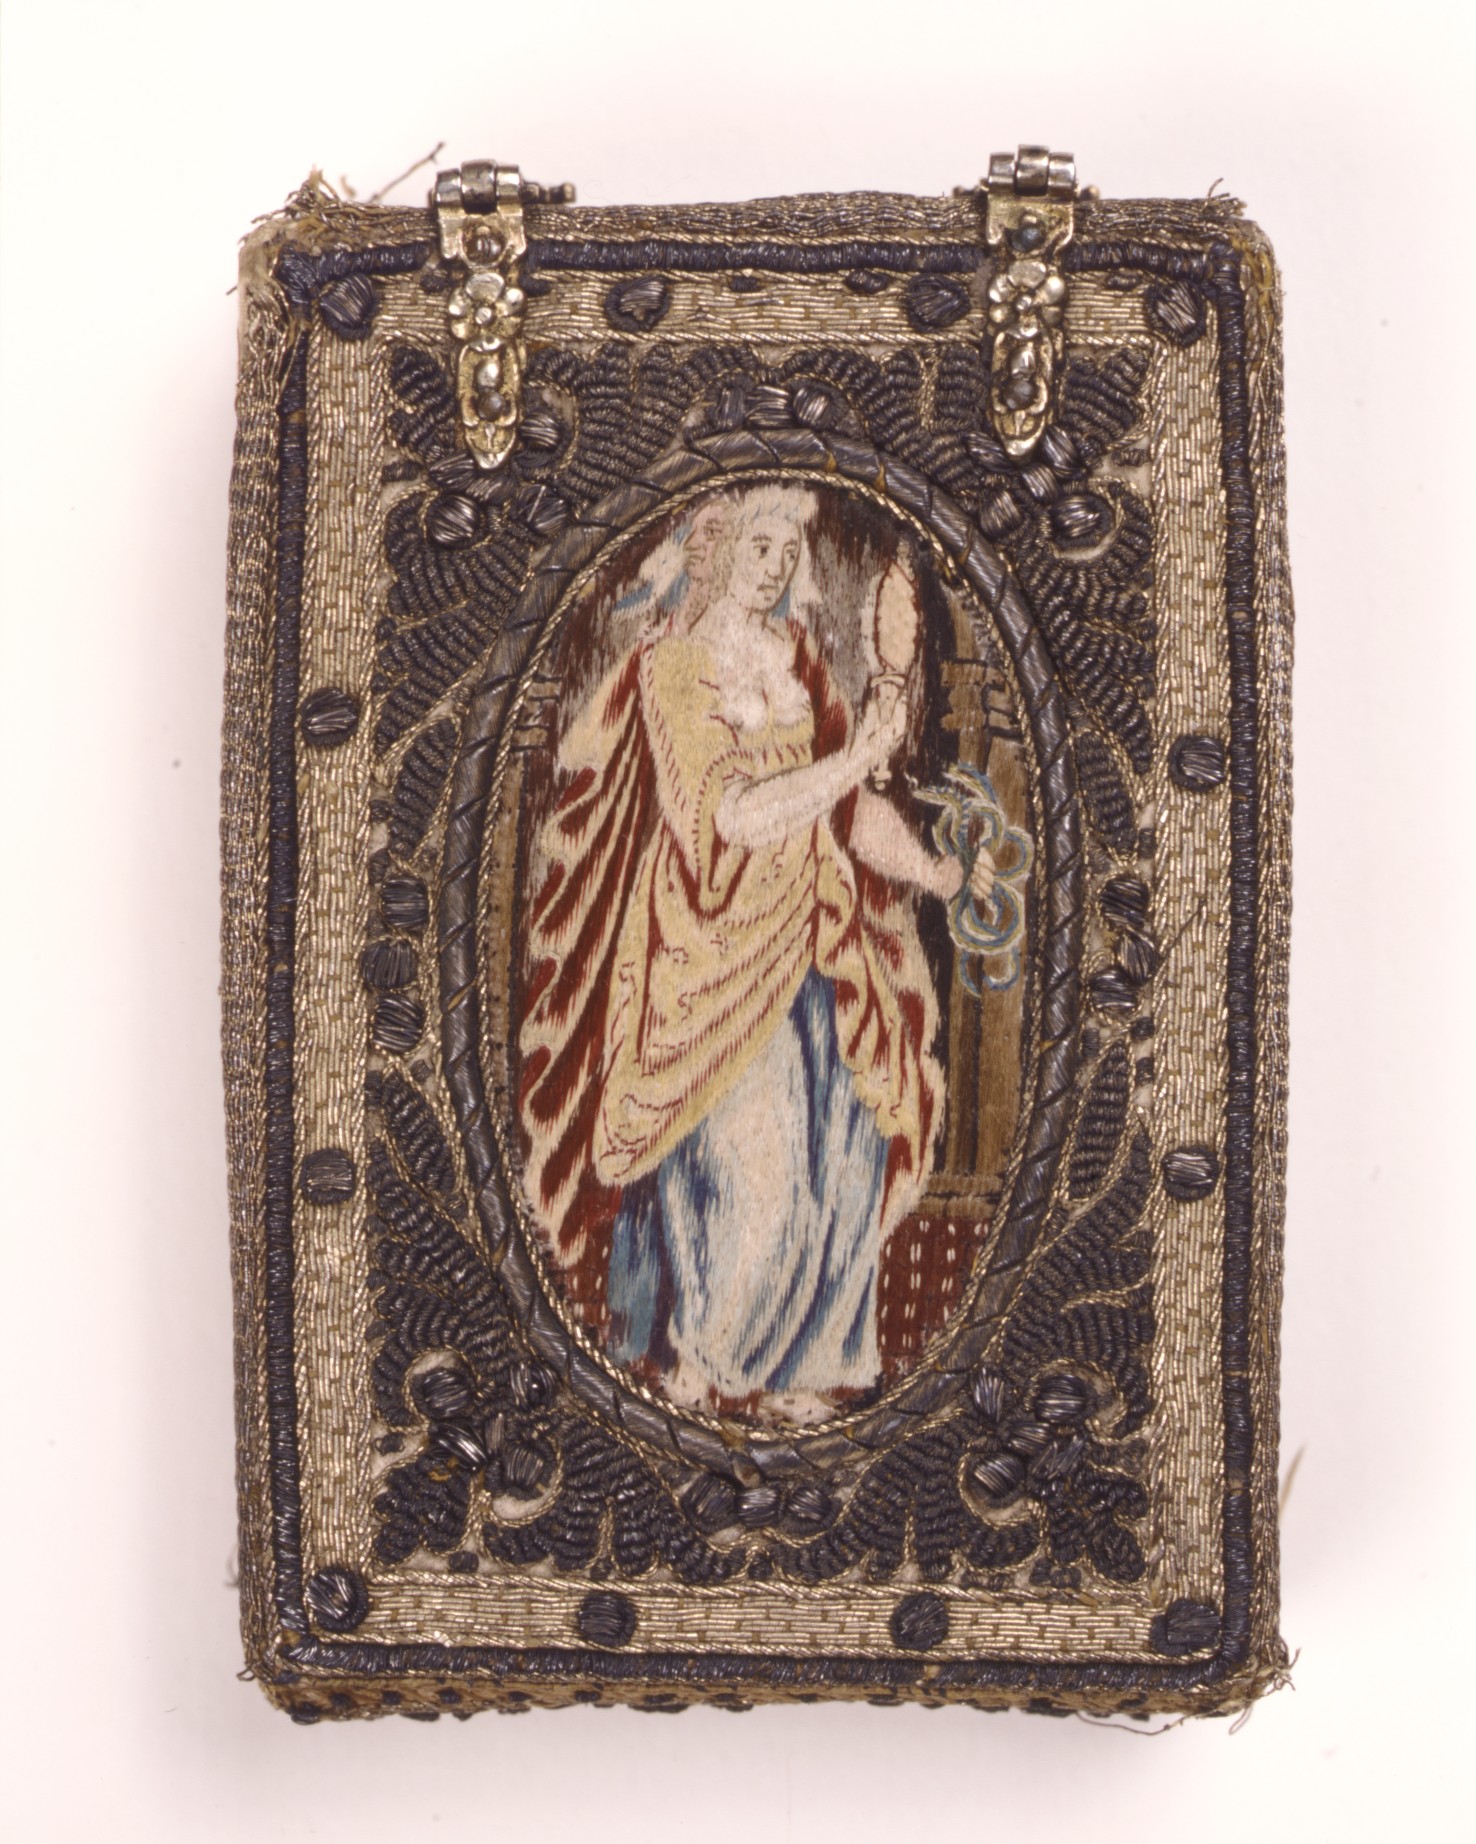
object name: book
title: Book with Needlework Cover with Figures of Justice and Prudence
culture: british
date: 1601-1700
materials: linen, metal, paper, silk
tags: women